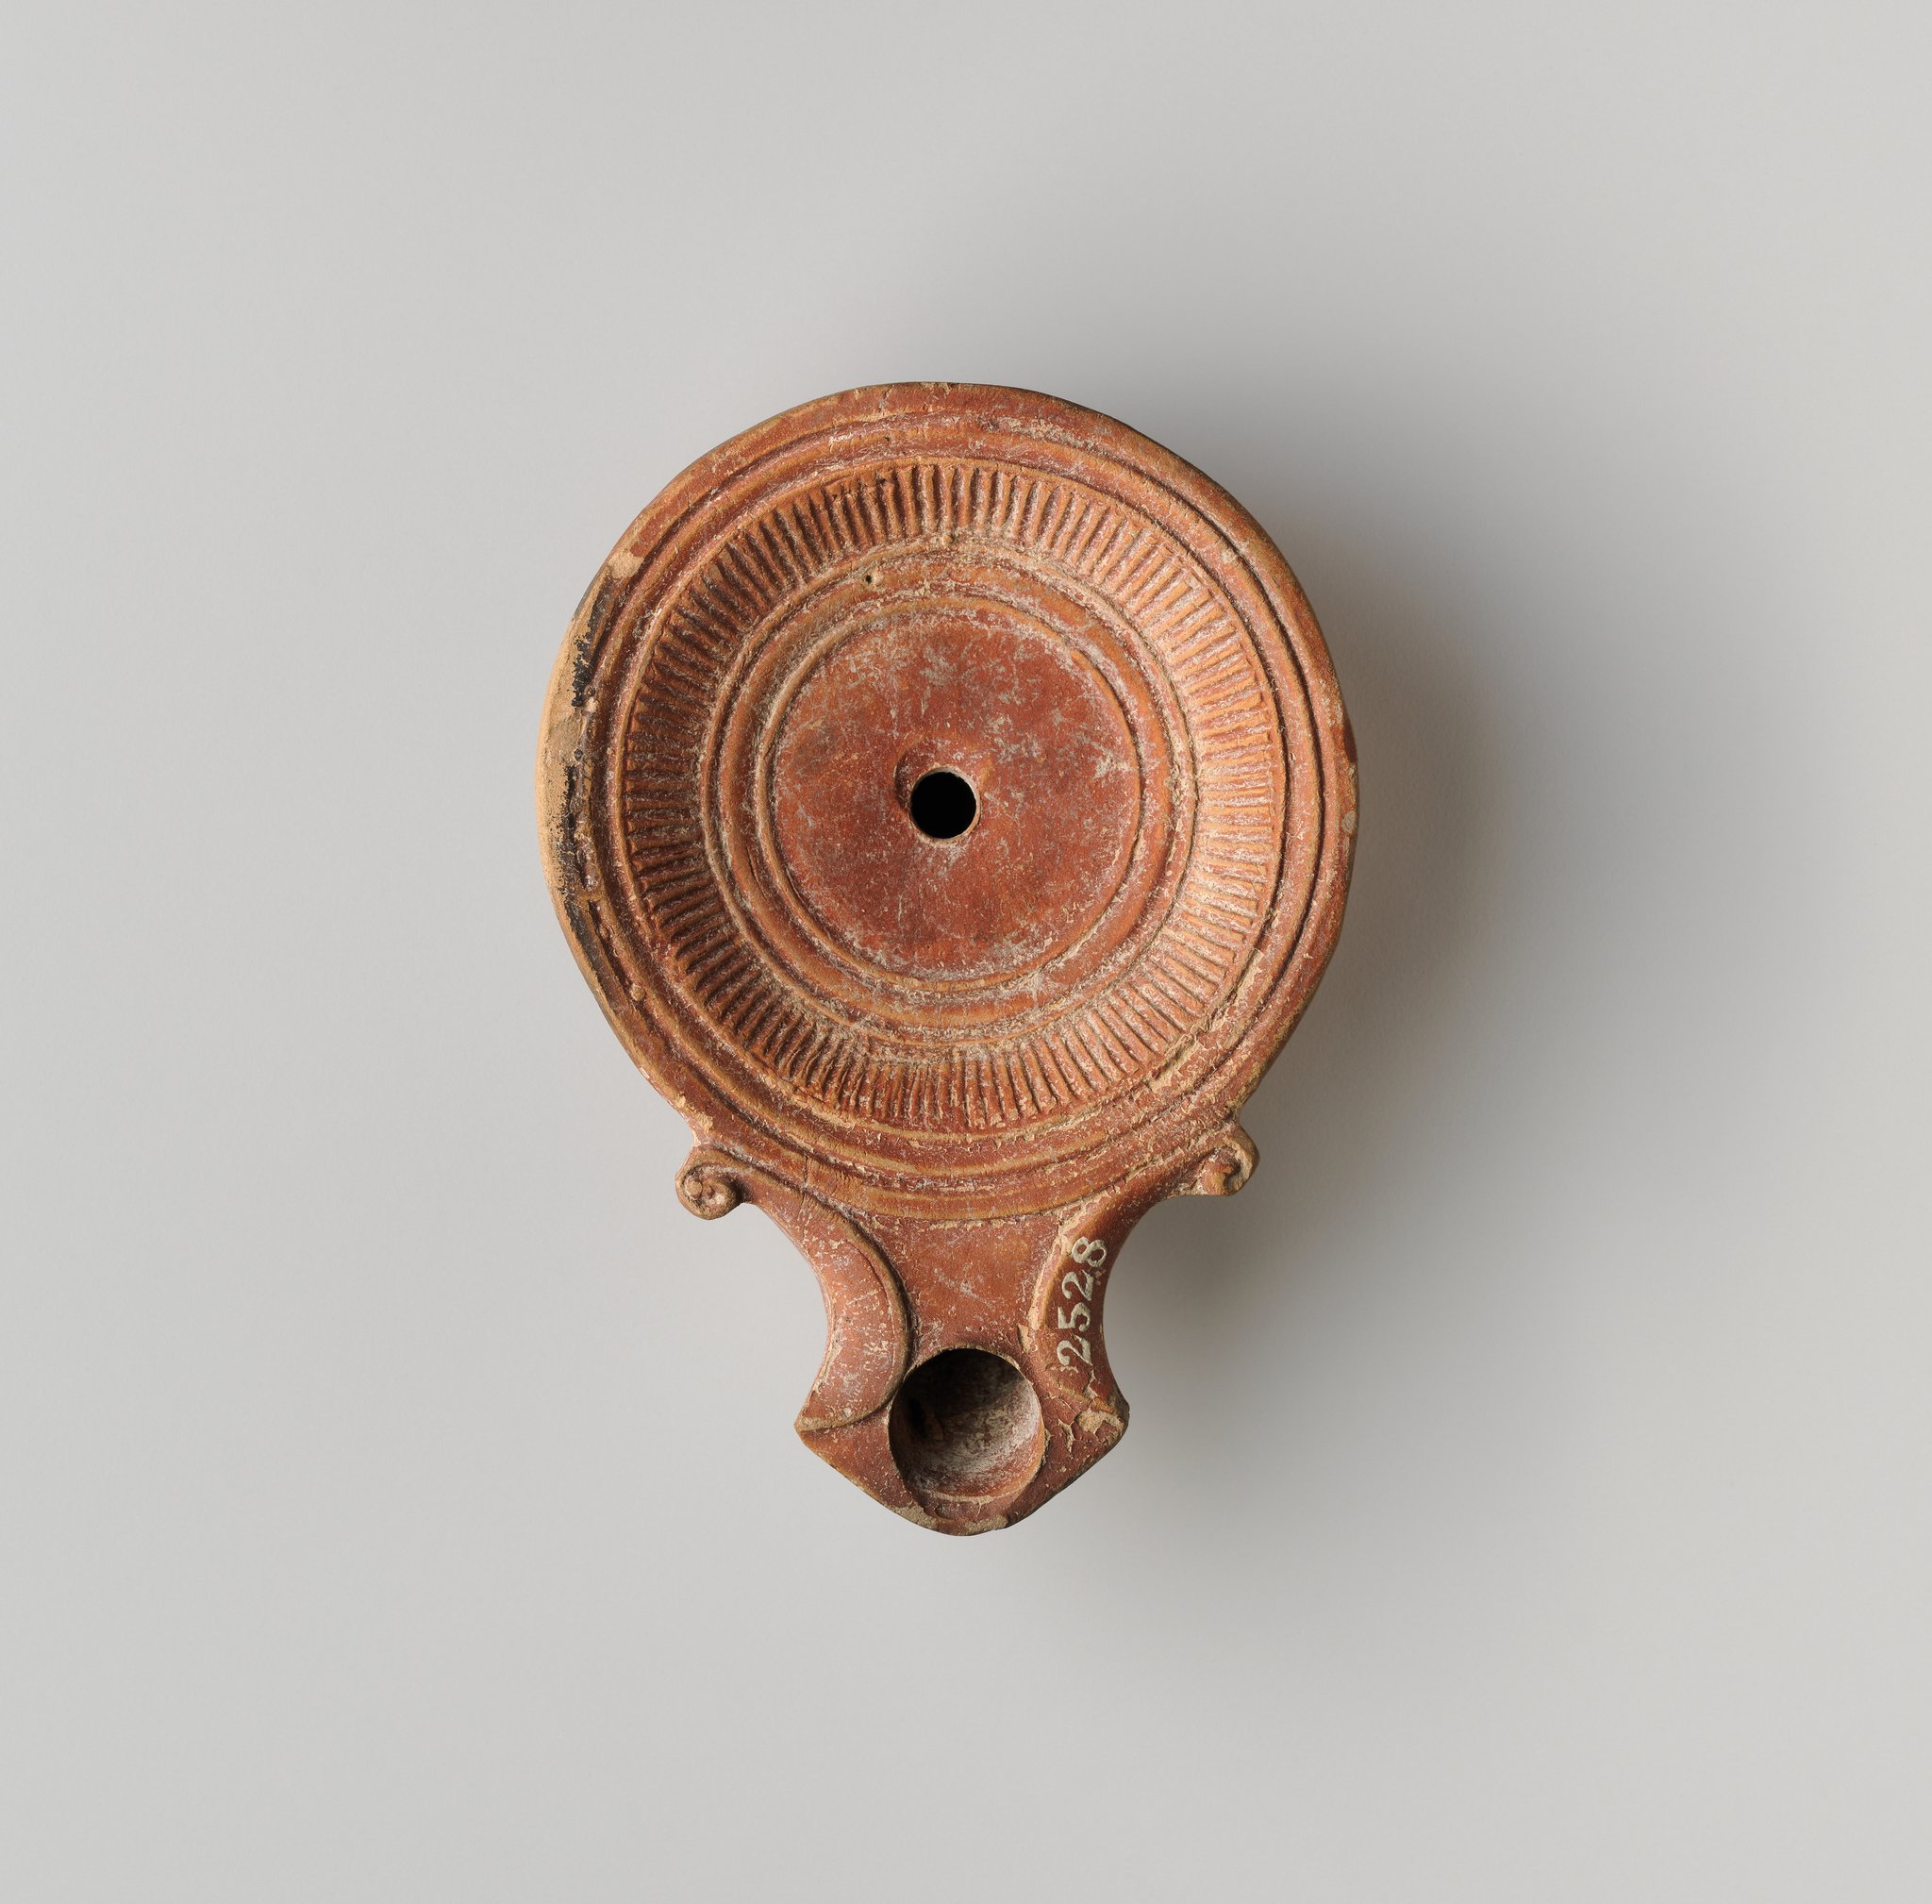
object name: lamp, concave top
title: Terracotta oil lamp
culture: roman, cypriot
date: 100 BCE-100 CE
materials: terracotta